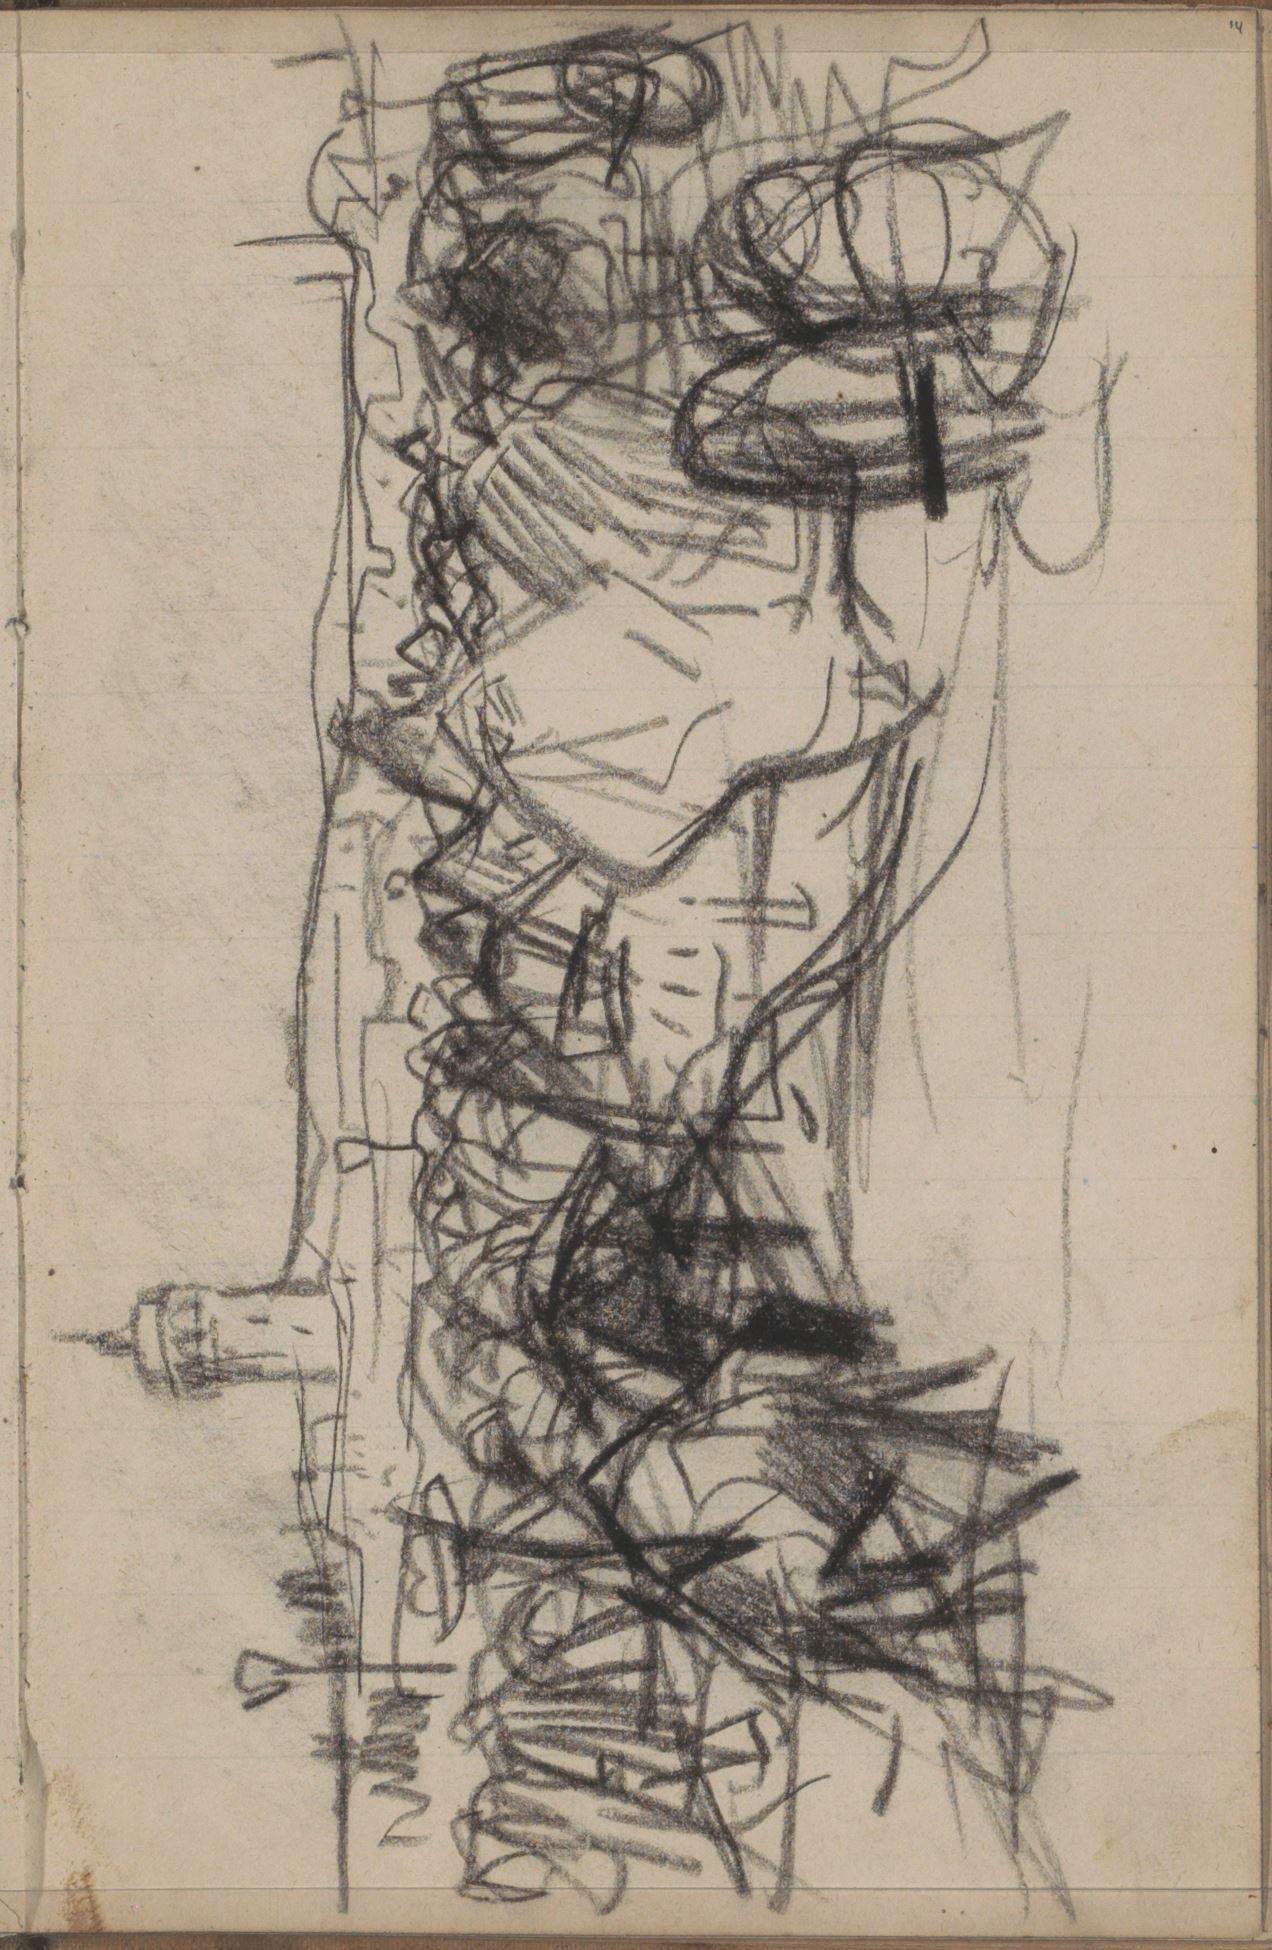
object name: sketchbook leaf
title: Figuren met op de achtergrond de Galatatoren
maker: marius bauer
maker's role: draughtsman, print maker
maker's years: 1867-1932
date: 1888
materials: chalk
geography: istanbul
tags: city-view, and landscape with man-made constructions, towers ~ fortified city, temple, shrine ~ islam, mohammedanism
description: Tevens op de achtergrond het silhouet van een moskee. Pagina 14 uit een schetsboek met 56 bladen.